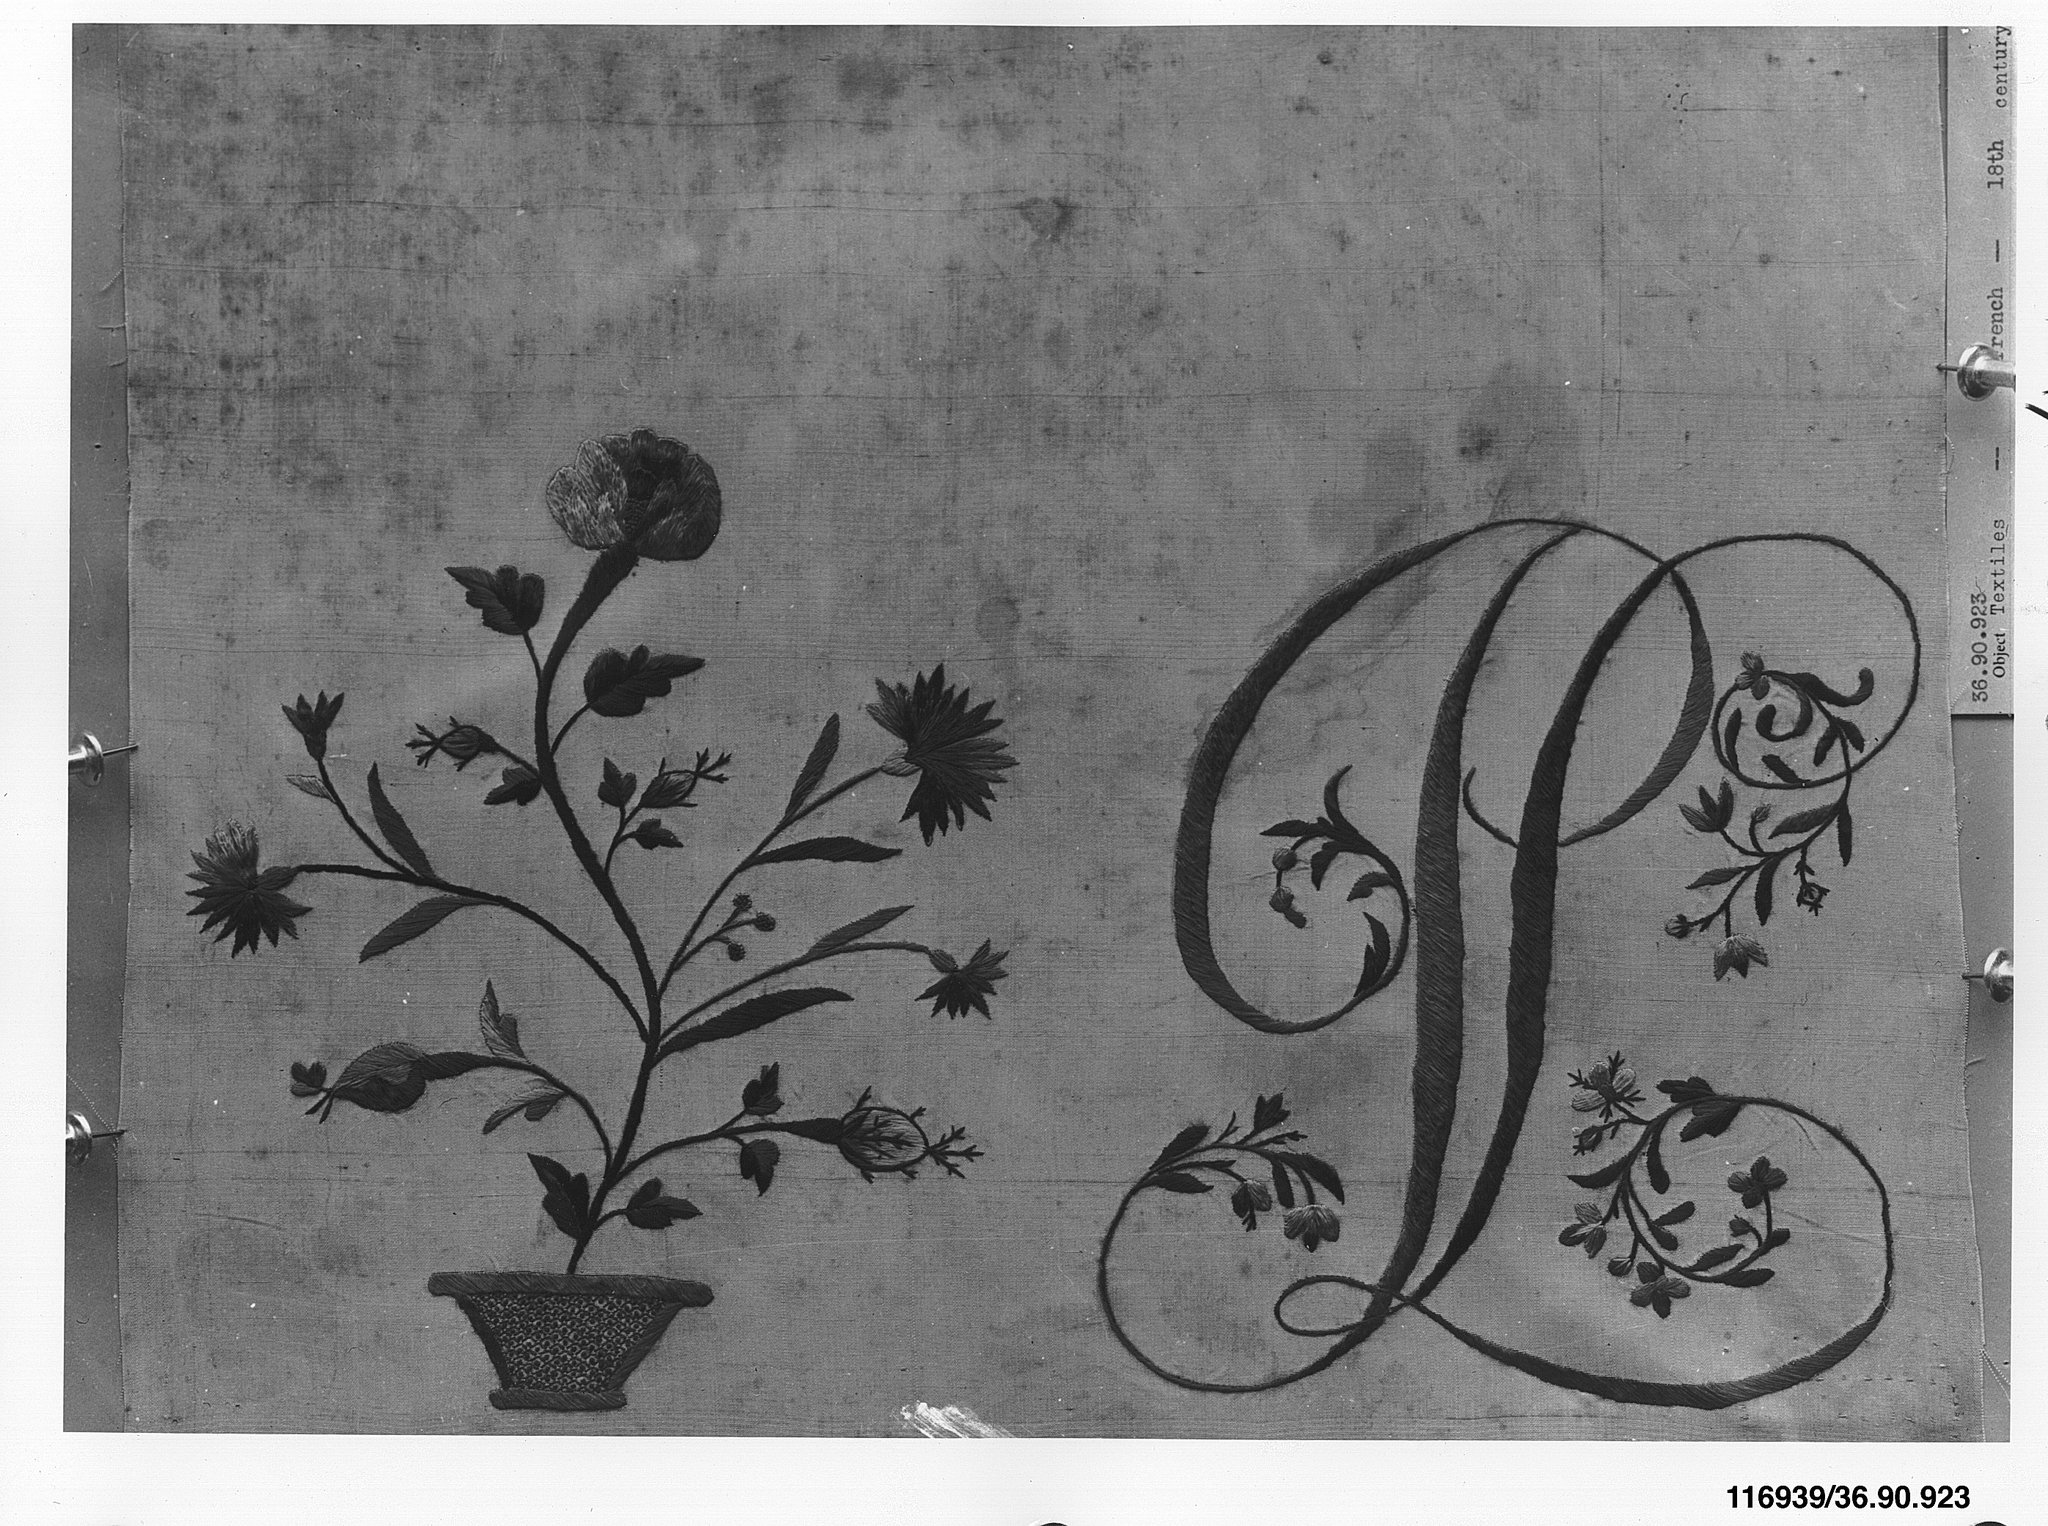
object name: piece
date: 1701-1800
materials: silk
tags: plants,insignia